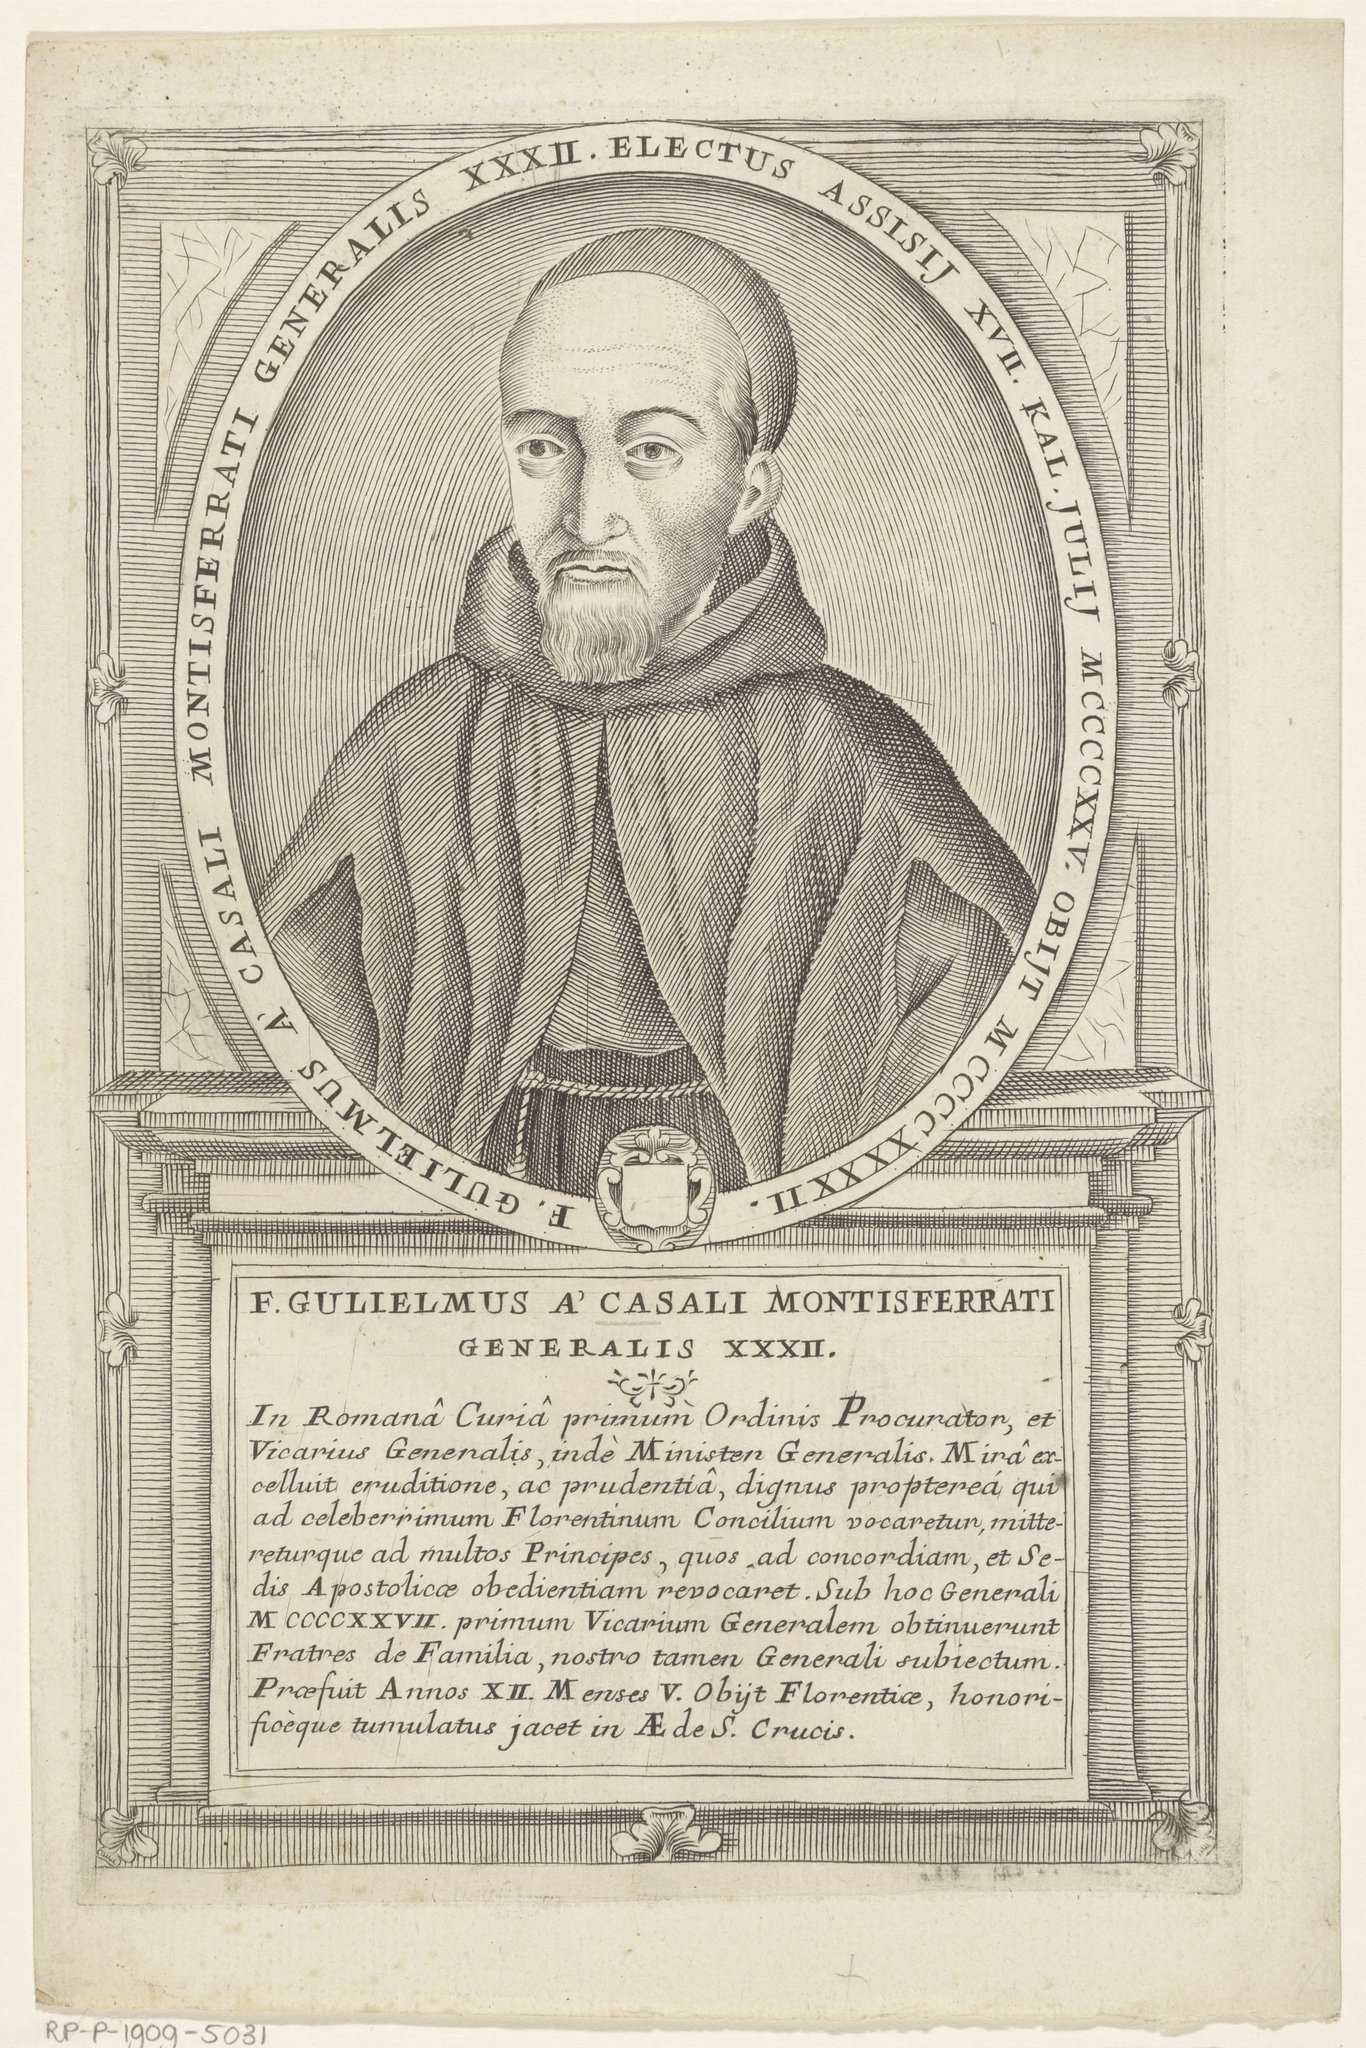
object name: print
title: Portret van Guillermo Robazoglio da Casale, 32ste Minister Generaal van de franciscaner orde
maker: antonio luciani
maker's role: print maker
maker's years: 1700-1738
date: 1710-1738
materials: paper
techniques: engraving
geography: italy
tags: historical persons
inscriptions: collector's mark: Lugt 2228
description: Deze prent maakt deel uit van een groep van 60 portretten.